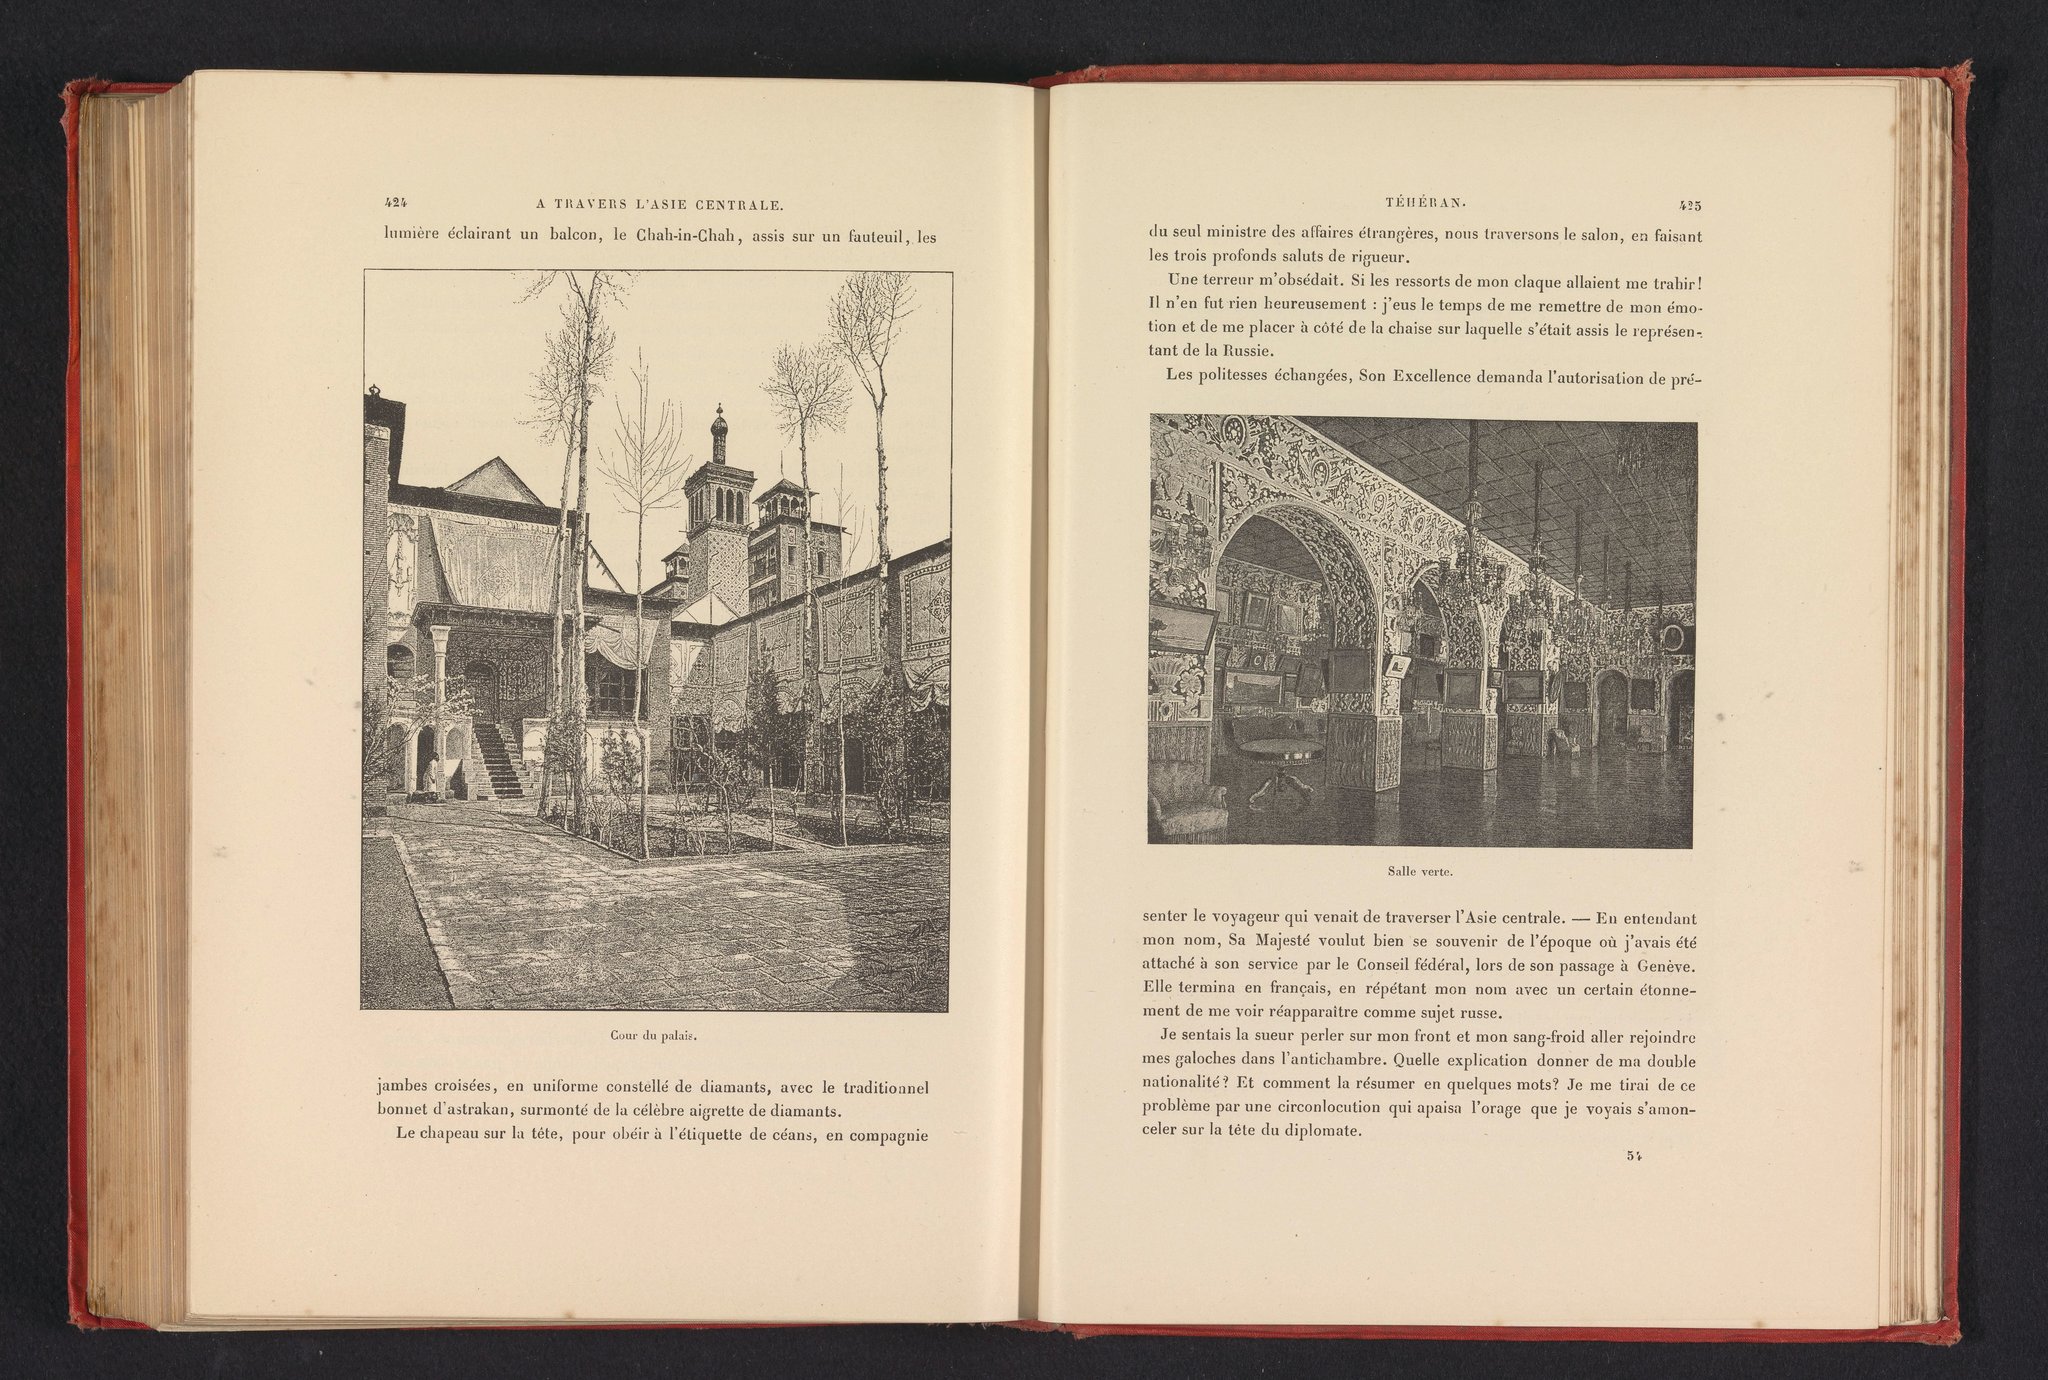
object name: page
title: Cour du palais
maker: Anonymous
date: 1869-1885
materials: paper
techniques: autotype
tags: palace, courtyard